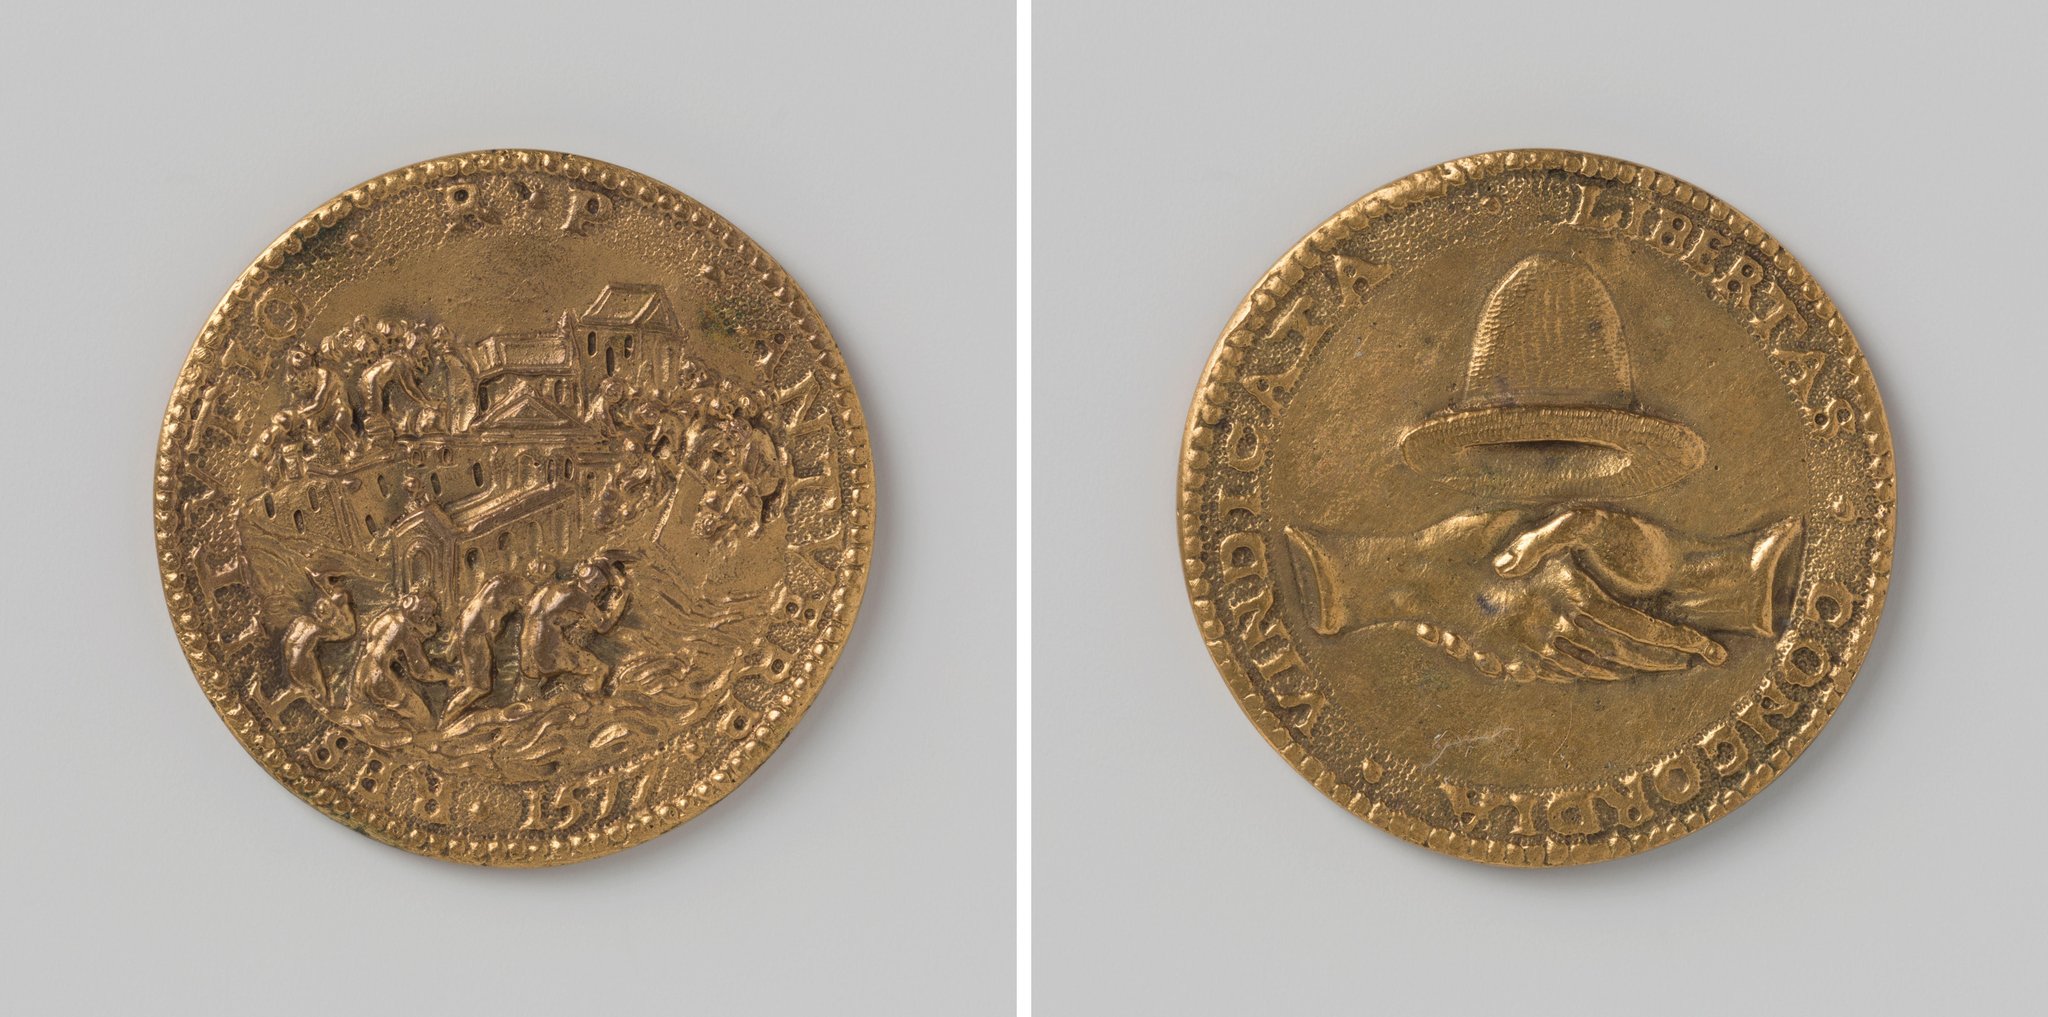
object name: history medal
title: Slechten van het kasteel van Antwerpen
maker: Anonymous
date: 1577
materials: gold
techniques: casting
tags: antwerp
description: Gouden penning. Voorzijde: groot aantal mensen, dat bezig is met houwelen e.d. slot van Antwerpen afte breken binnen omschrift. Keerzijde: vrijheidshoed boven twee ineen geslagen handen binnen omschrift